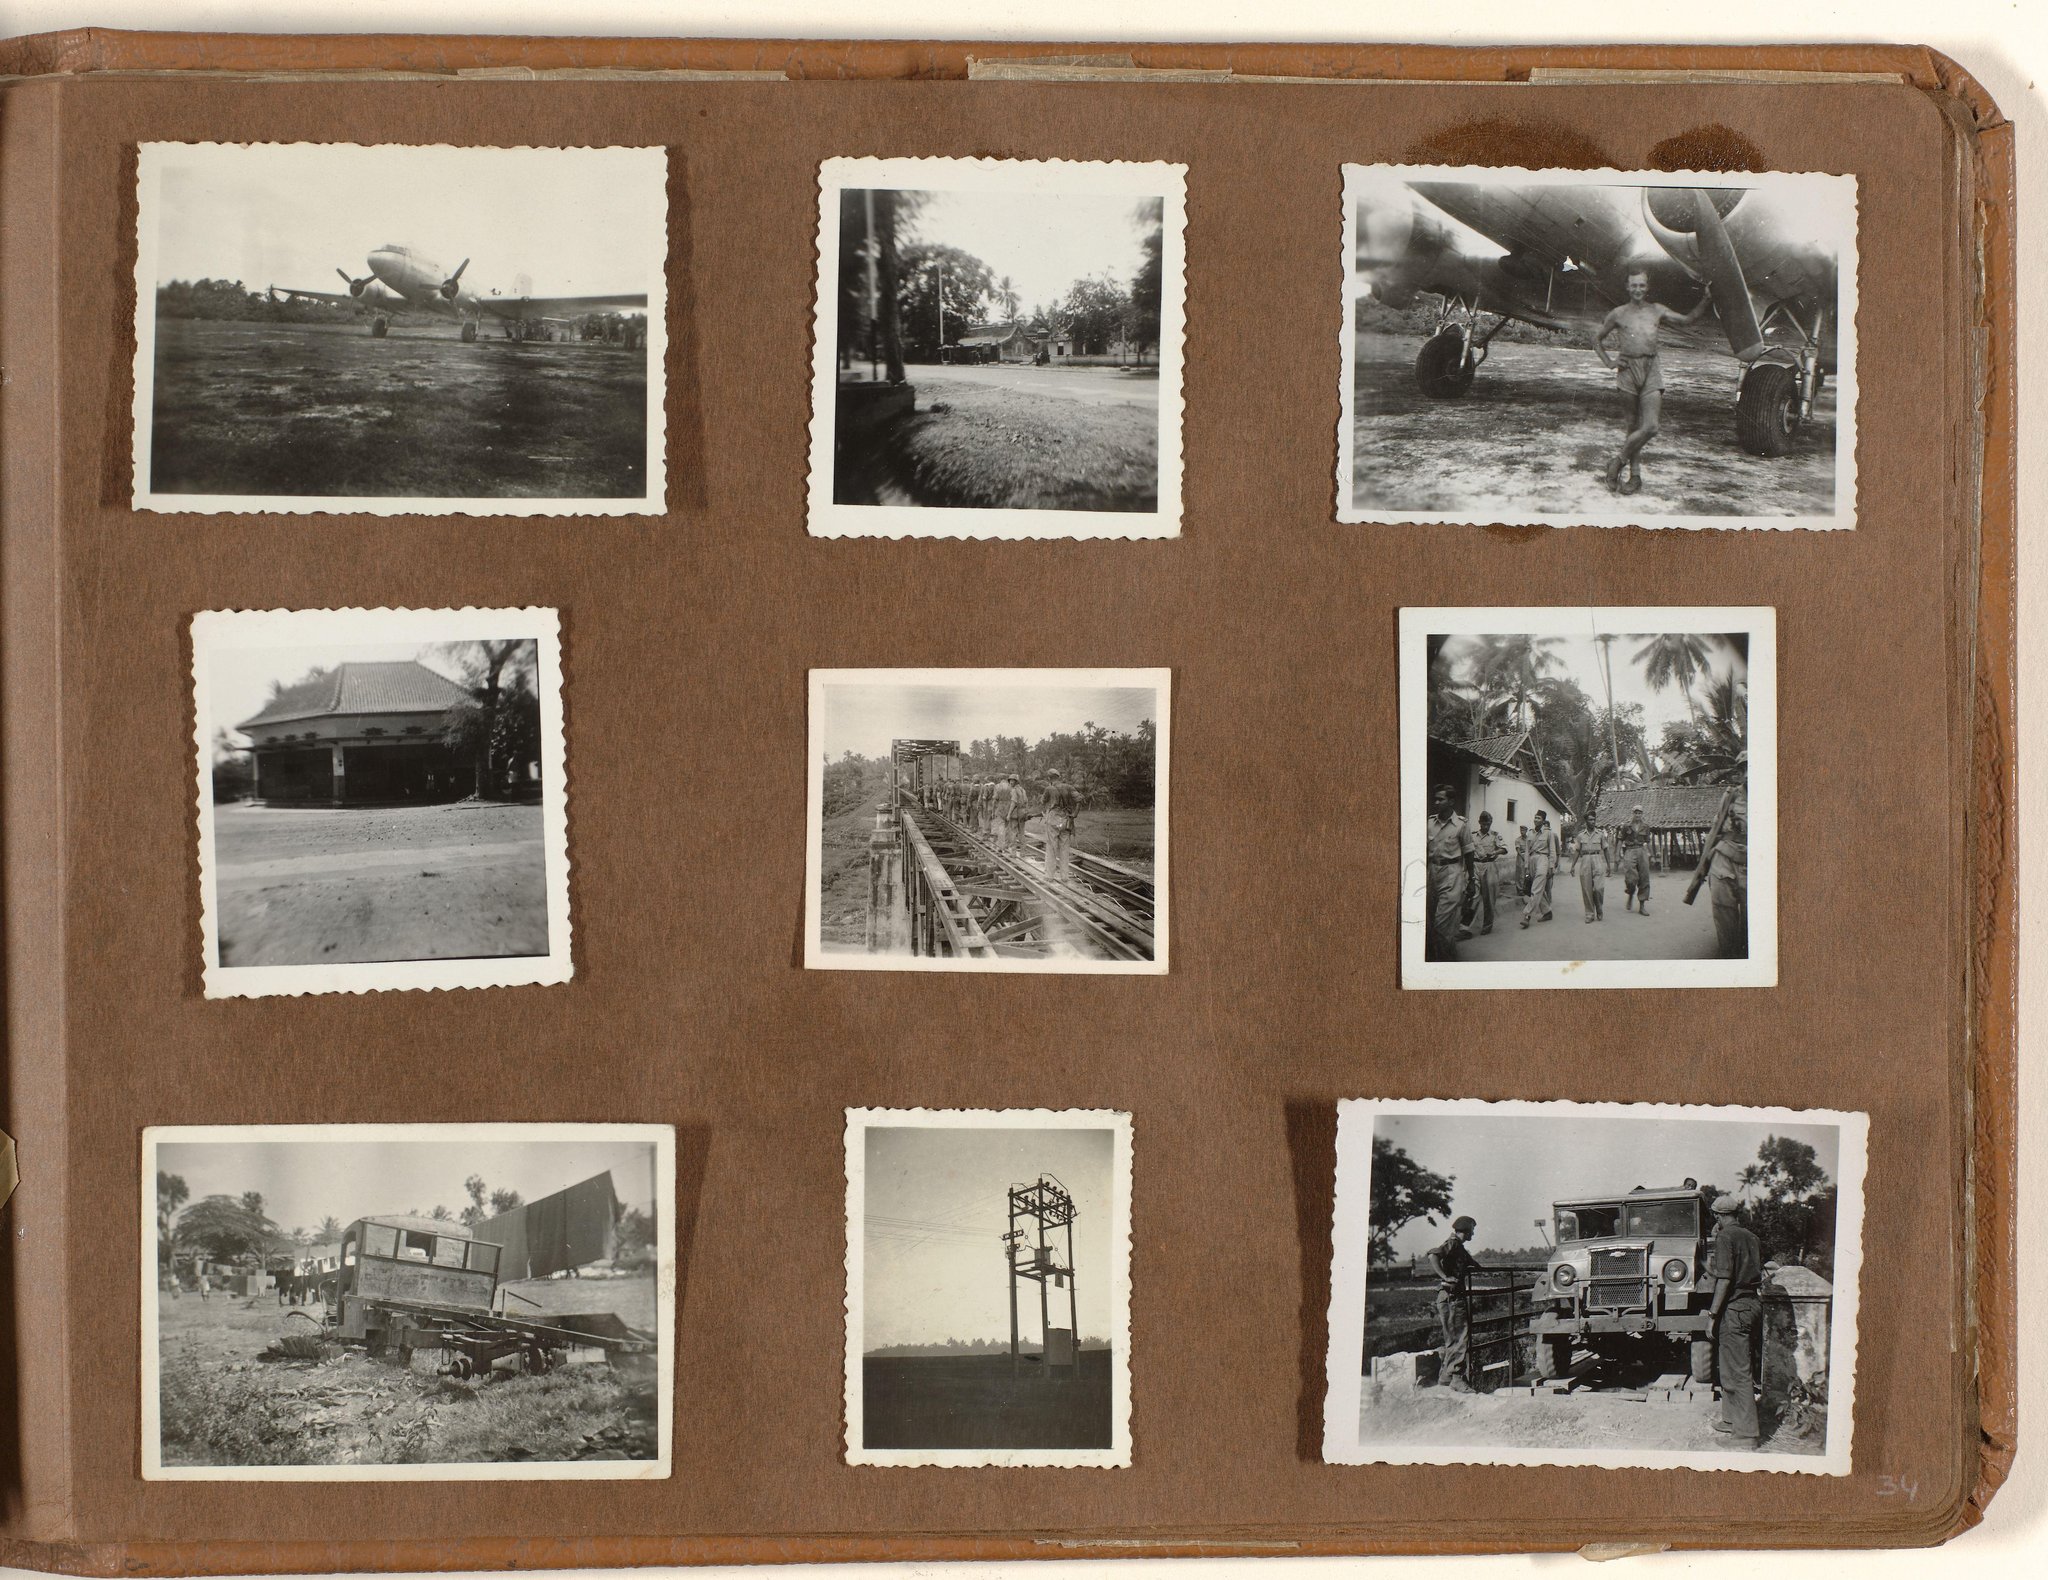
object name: photograph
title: Militaire activiteiten rond Jogyakarta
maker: Anonymous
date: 1949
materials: paper, photographic support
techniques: photography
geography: jogjakarta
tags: airfield, airport, guerilla warfare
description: Albumblad met negen foto's. Militairen rondom Jogyakarta. Twee foto's van een vliegveld, waarschijnlijk Mugowo. Verder een patrouille op een spoorbrug, een bezoek aan een kampong met Indonesische militairen van de TNI en een verwoeste vrachtauto langs de kant van de weg. Waarschijnlijk rond Jogyakarta en Klaten.